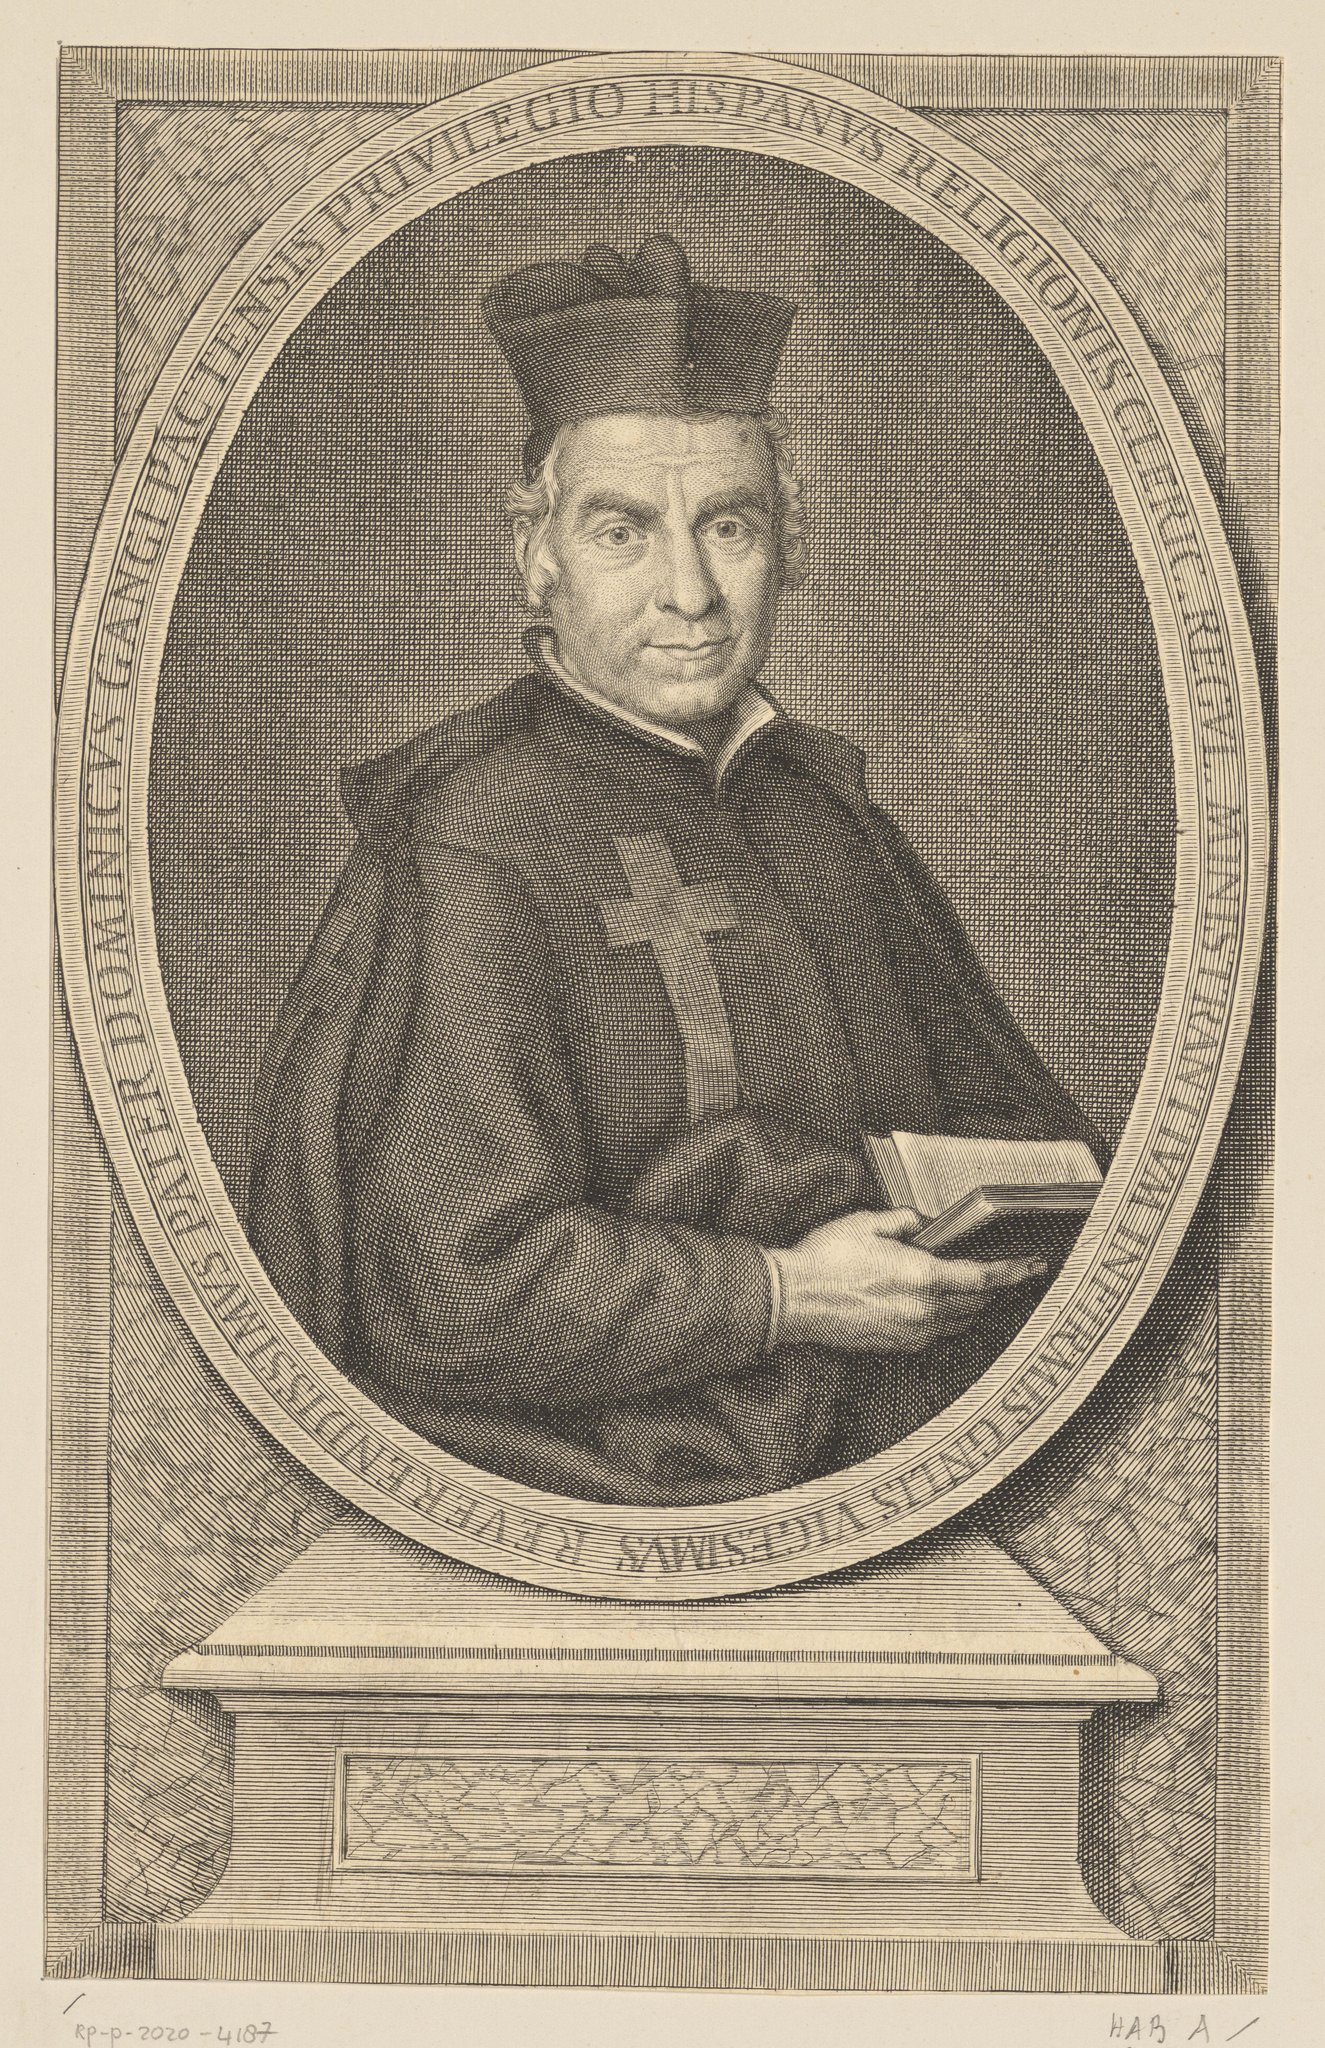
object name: print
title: Portret van Dominico Gangi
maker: benedikt horiat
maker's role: print maker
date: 1710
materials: paper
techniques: engraving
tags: priest, theologian, historical persons